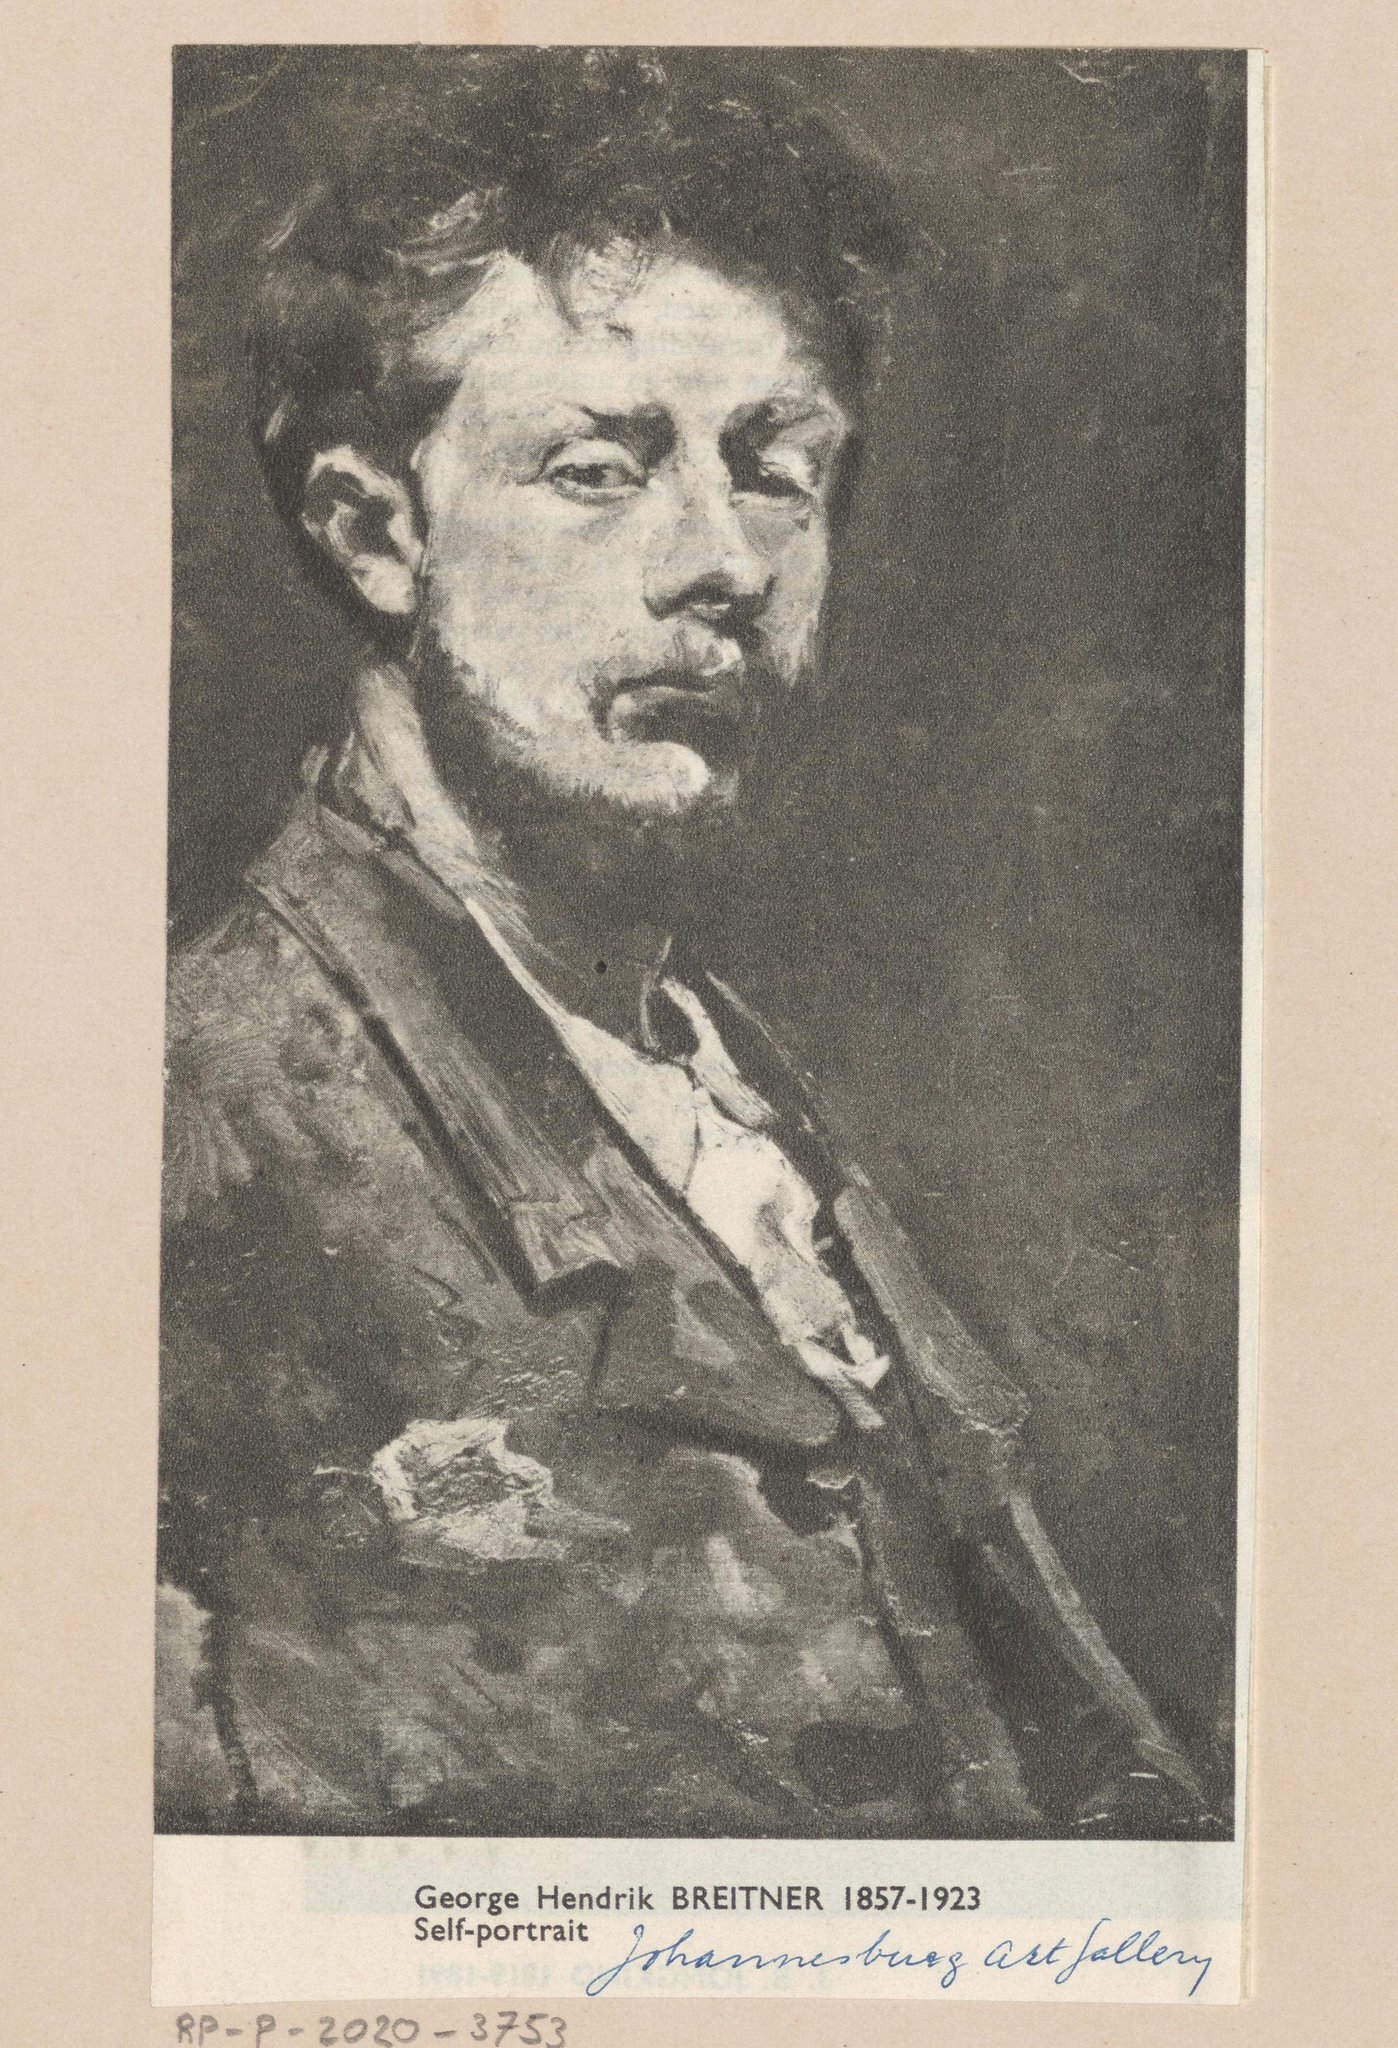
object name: photomechanical print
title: Portret van George Hendrik Breitner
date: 1923-1975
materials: paper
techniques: rotogravure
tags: rotterdam, amsterdam, painter, print maker, draughtsman, george hendrik breitner, historical persons, portrait, self-portrait of painter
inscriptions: inscription: ‘Johannesburg Art Gallery’